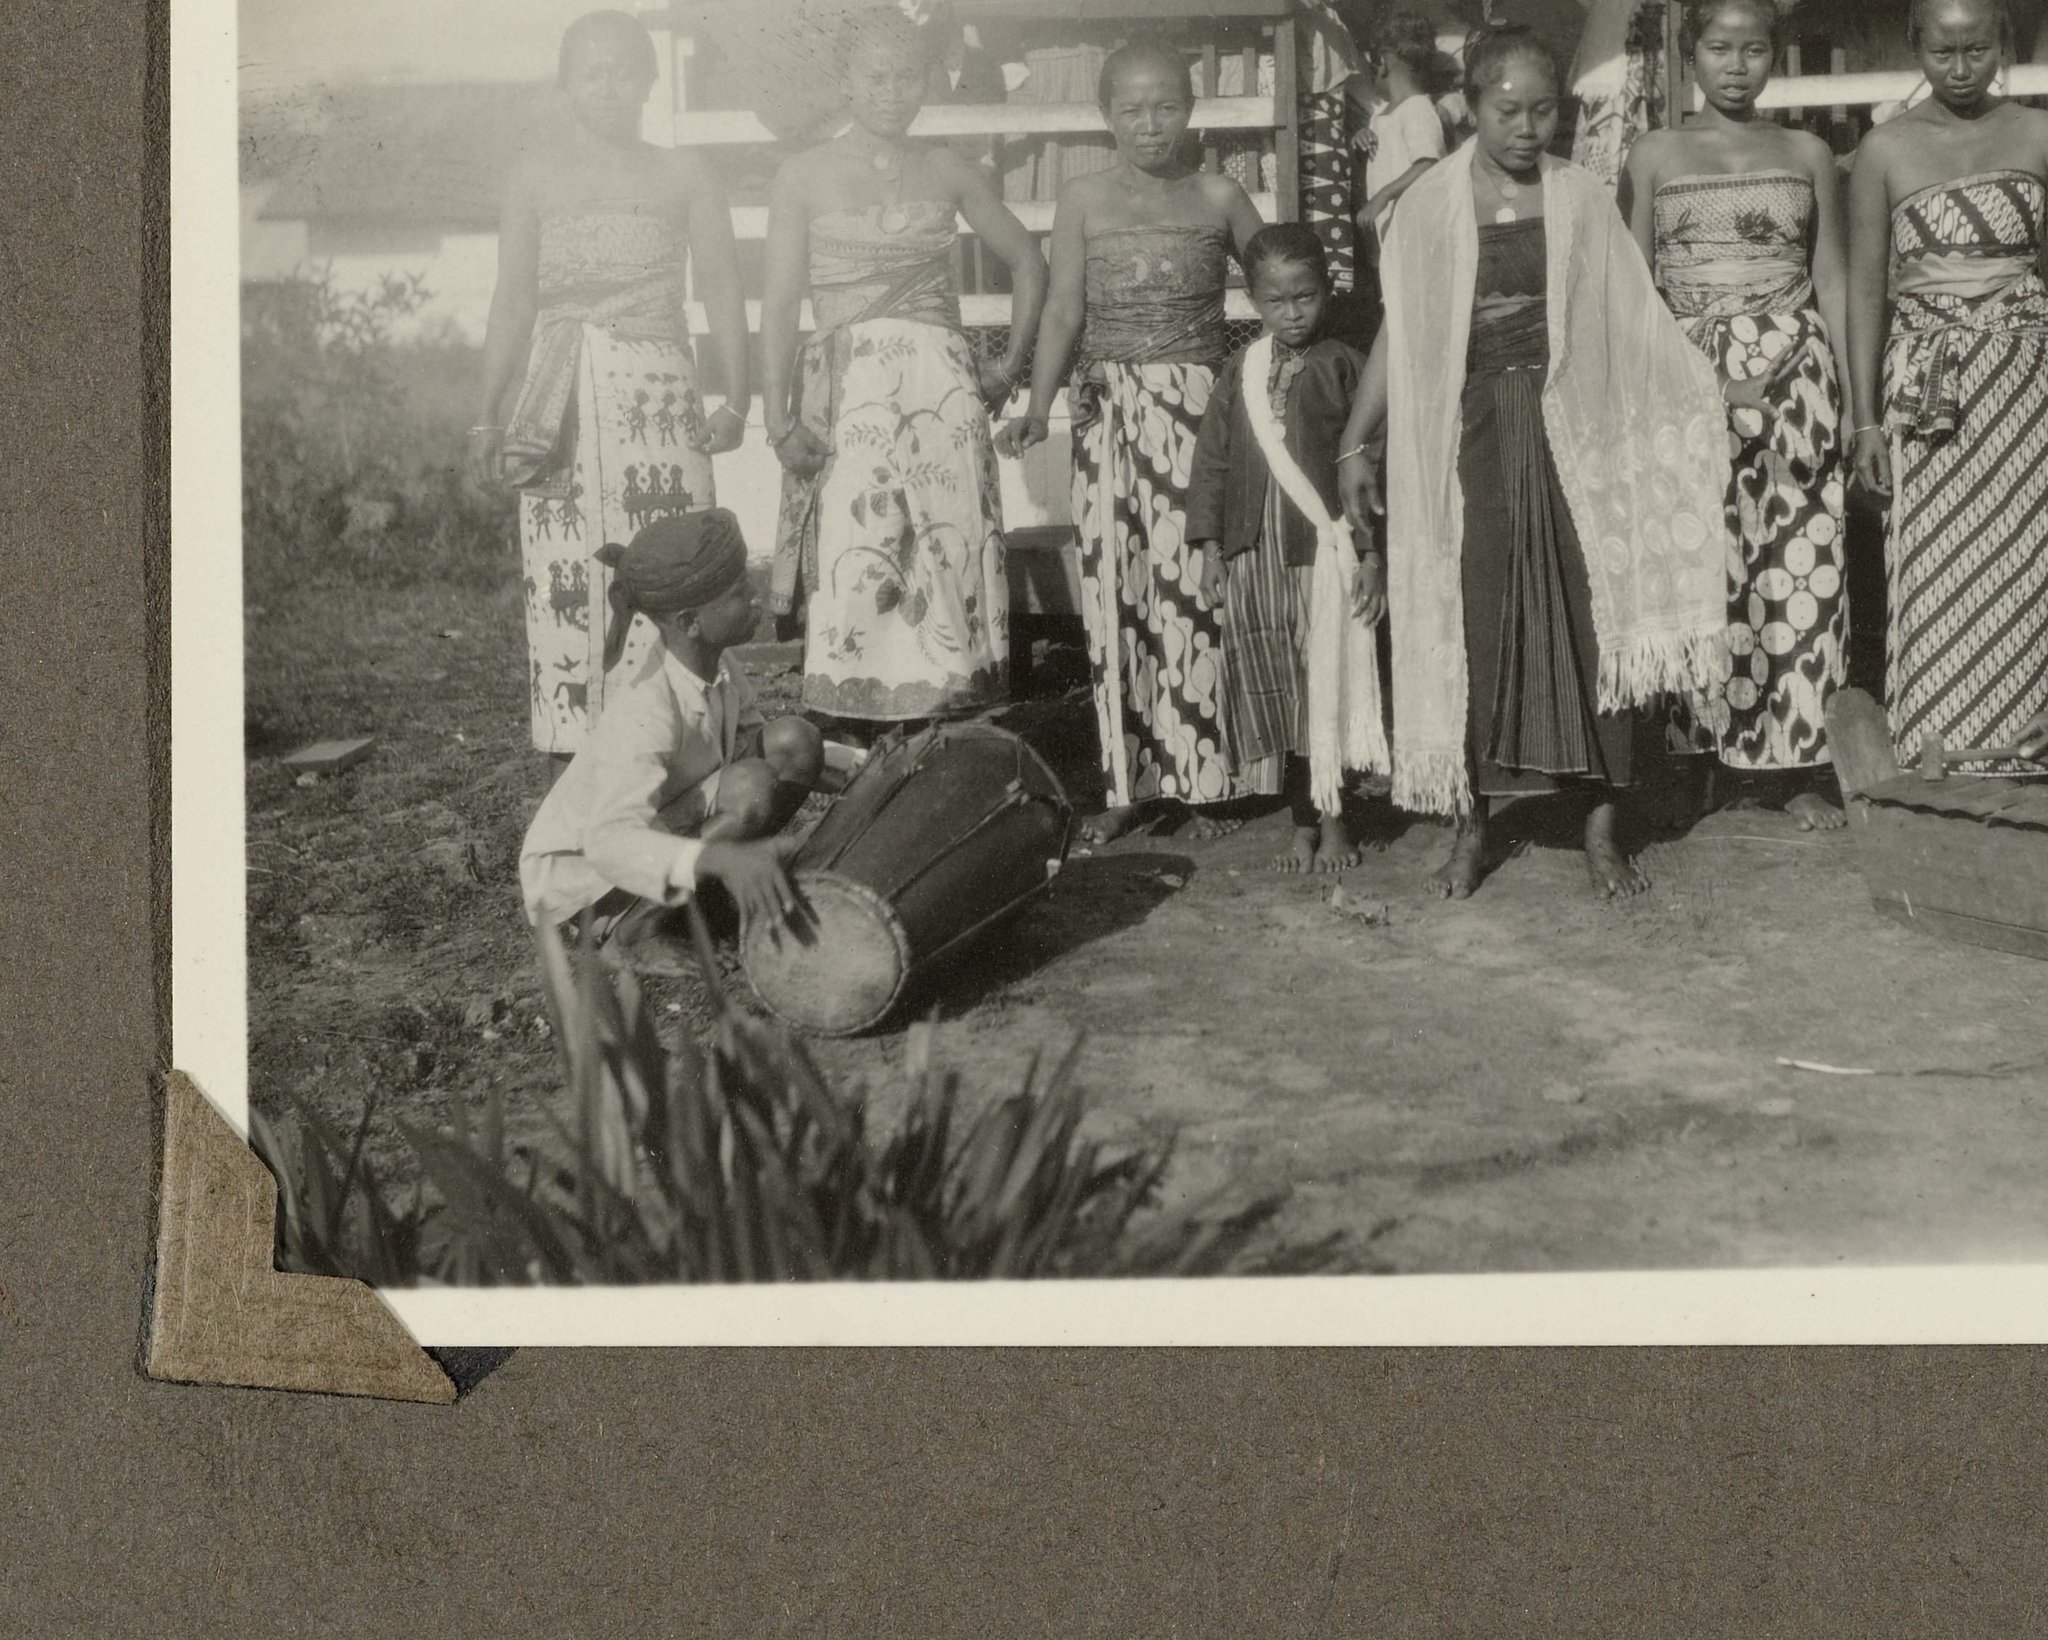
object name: photograph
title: Groep Javaanse vrouwen in Suriname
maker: Anonymous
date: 1925-1927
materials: photographic support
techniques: photography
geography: suriname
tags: historical persons not known by name - bb - woman, suriname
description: Groep Javaanse vrouwen in Suriname. Foto met hoekjes bevestigd op een bladzijde van een albumblad in het fotoalbum over de familie Jetten en het leven en werken in de mijnstad Moengo in Suriname rond 1927.